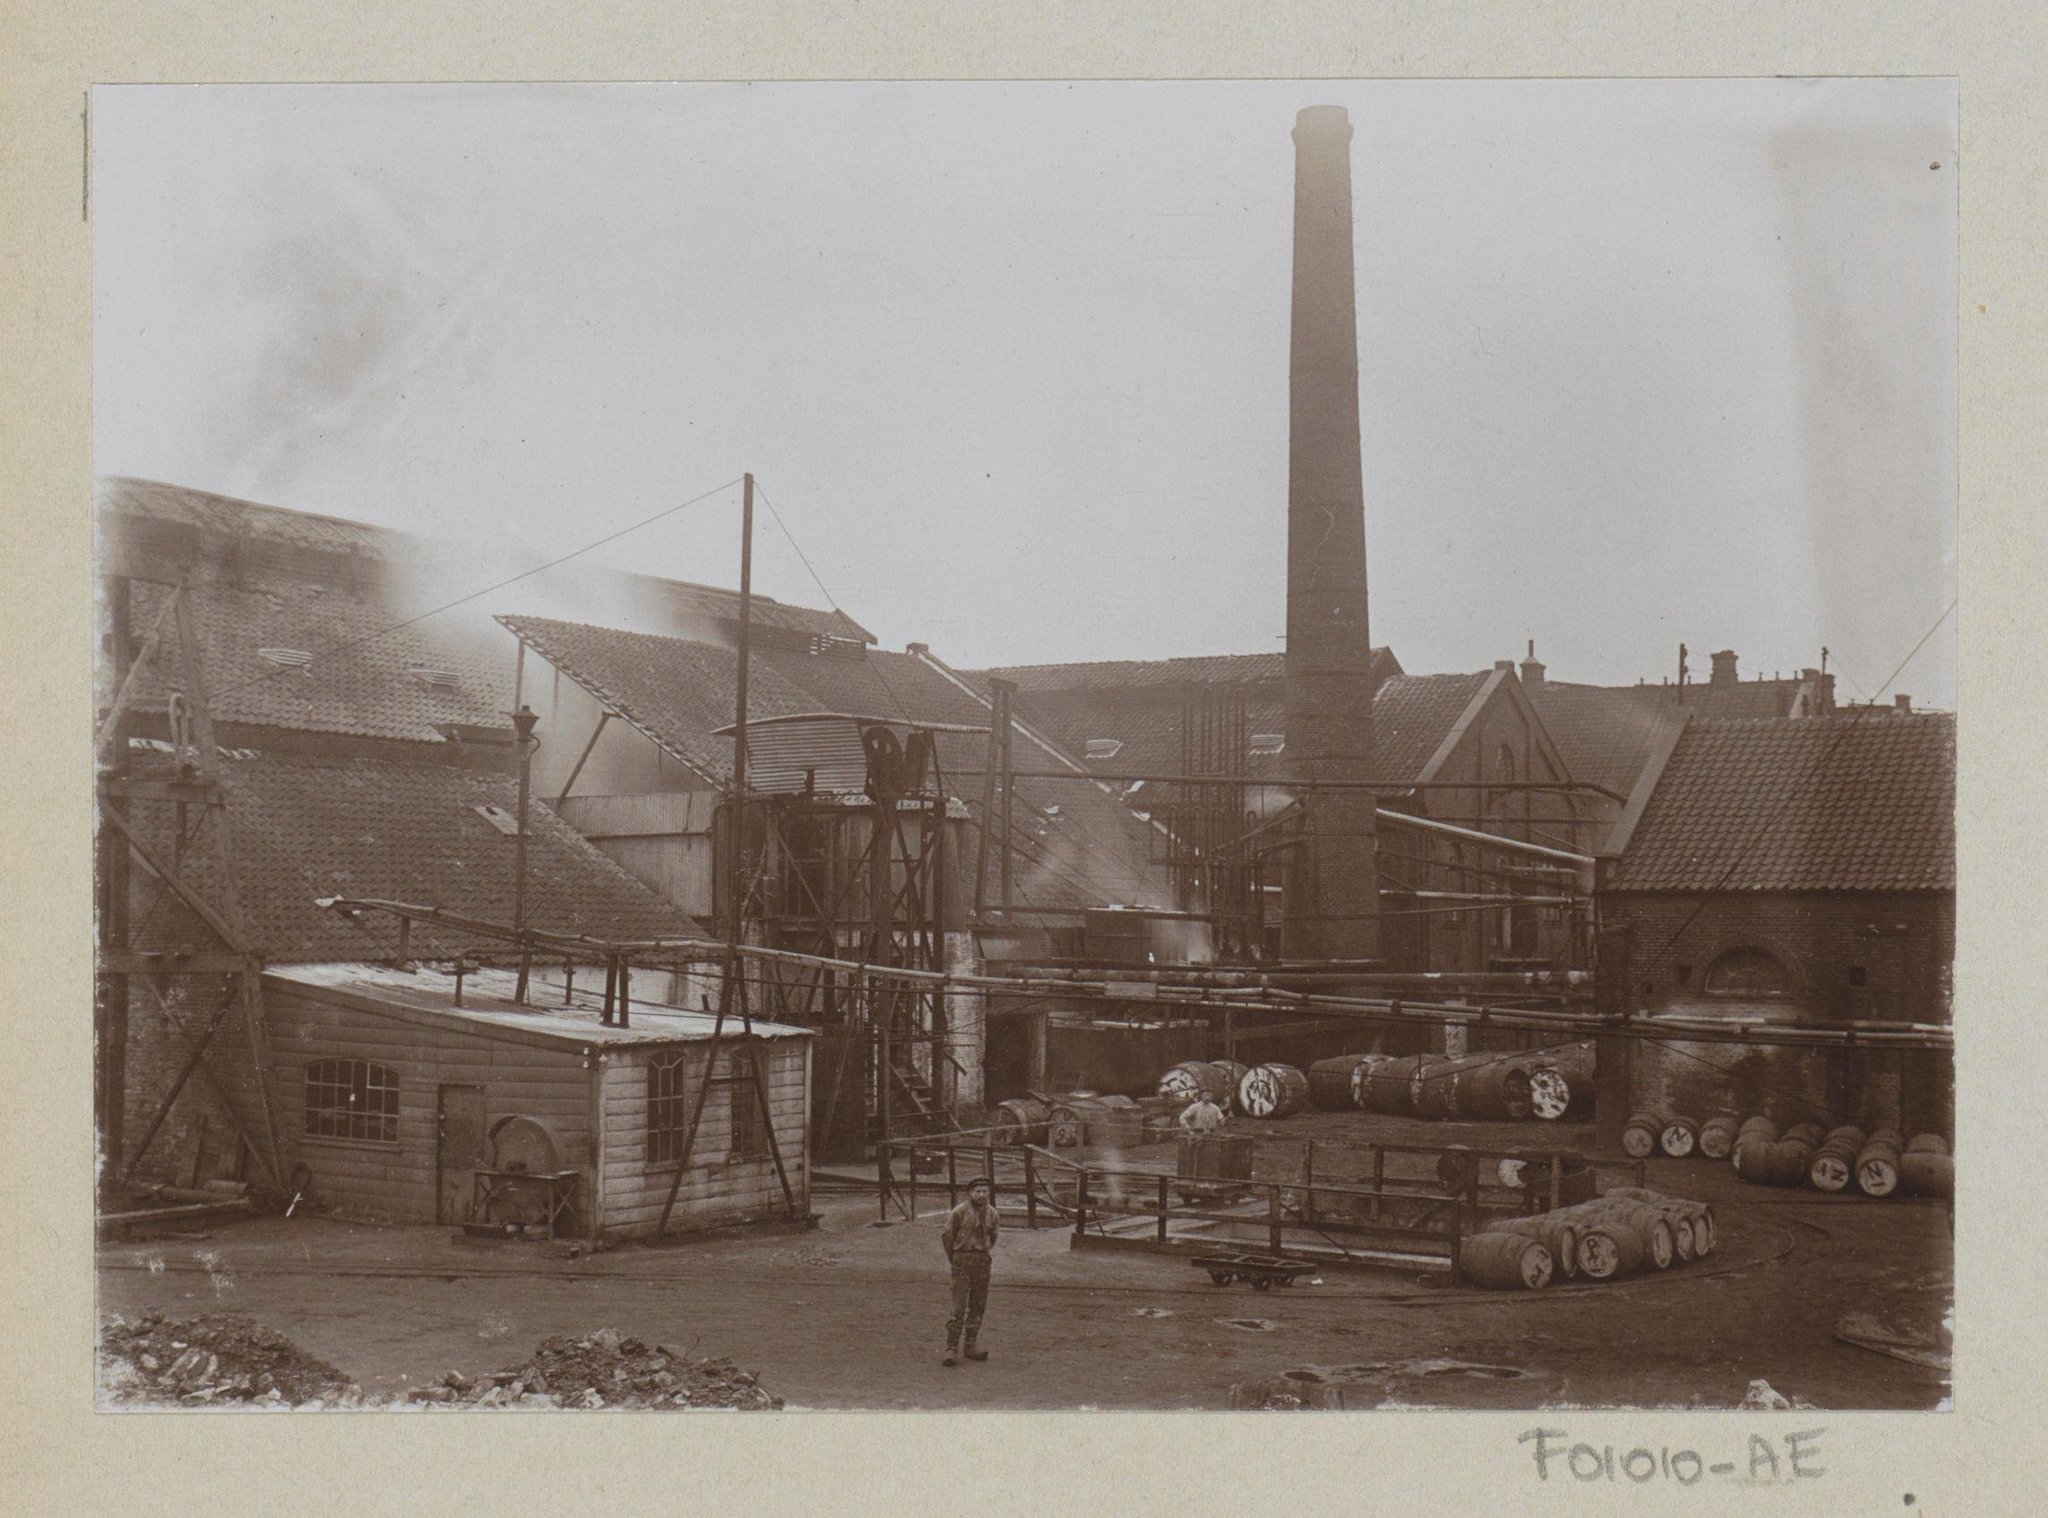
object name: photograph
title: Fabrieksterrein met gebouwen, een schoorsteen, houten vaten en een werknemer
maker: Anonymous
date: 1900-1910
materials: photographic support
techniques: collodion silver print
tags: smoke-stack, wooden container: barrel, cask (+ wood and other phytogenic material), factory-building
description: Onderdeel van Familiealbum met onder meer foto's van Wijnhandel Kraaij & Co. Bordeaux-Amsterdam.